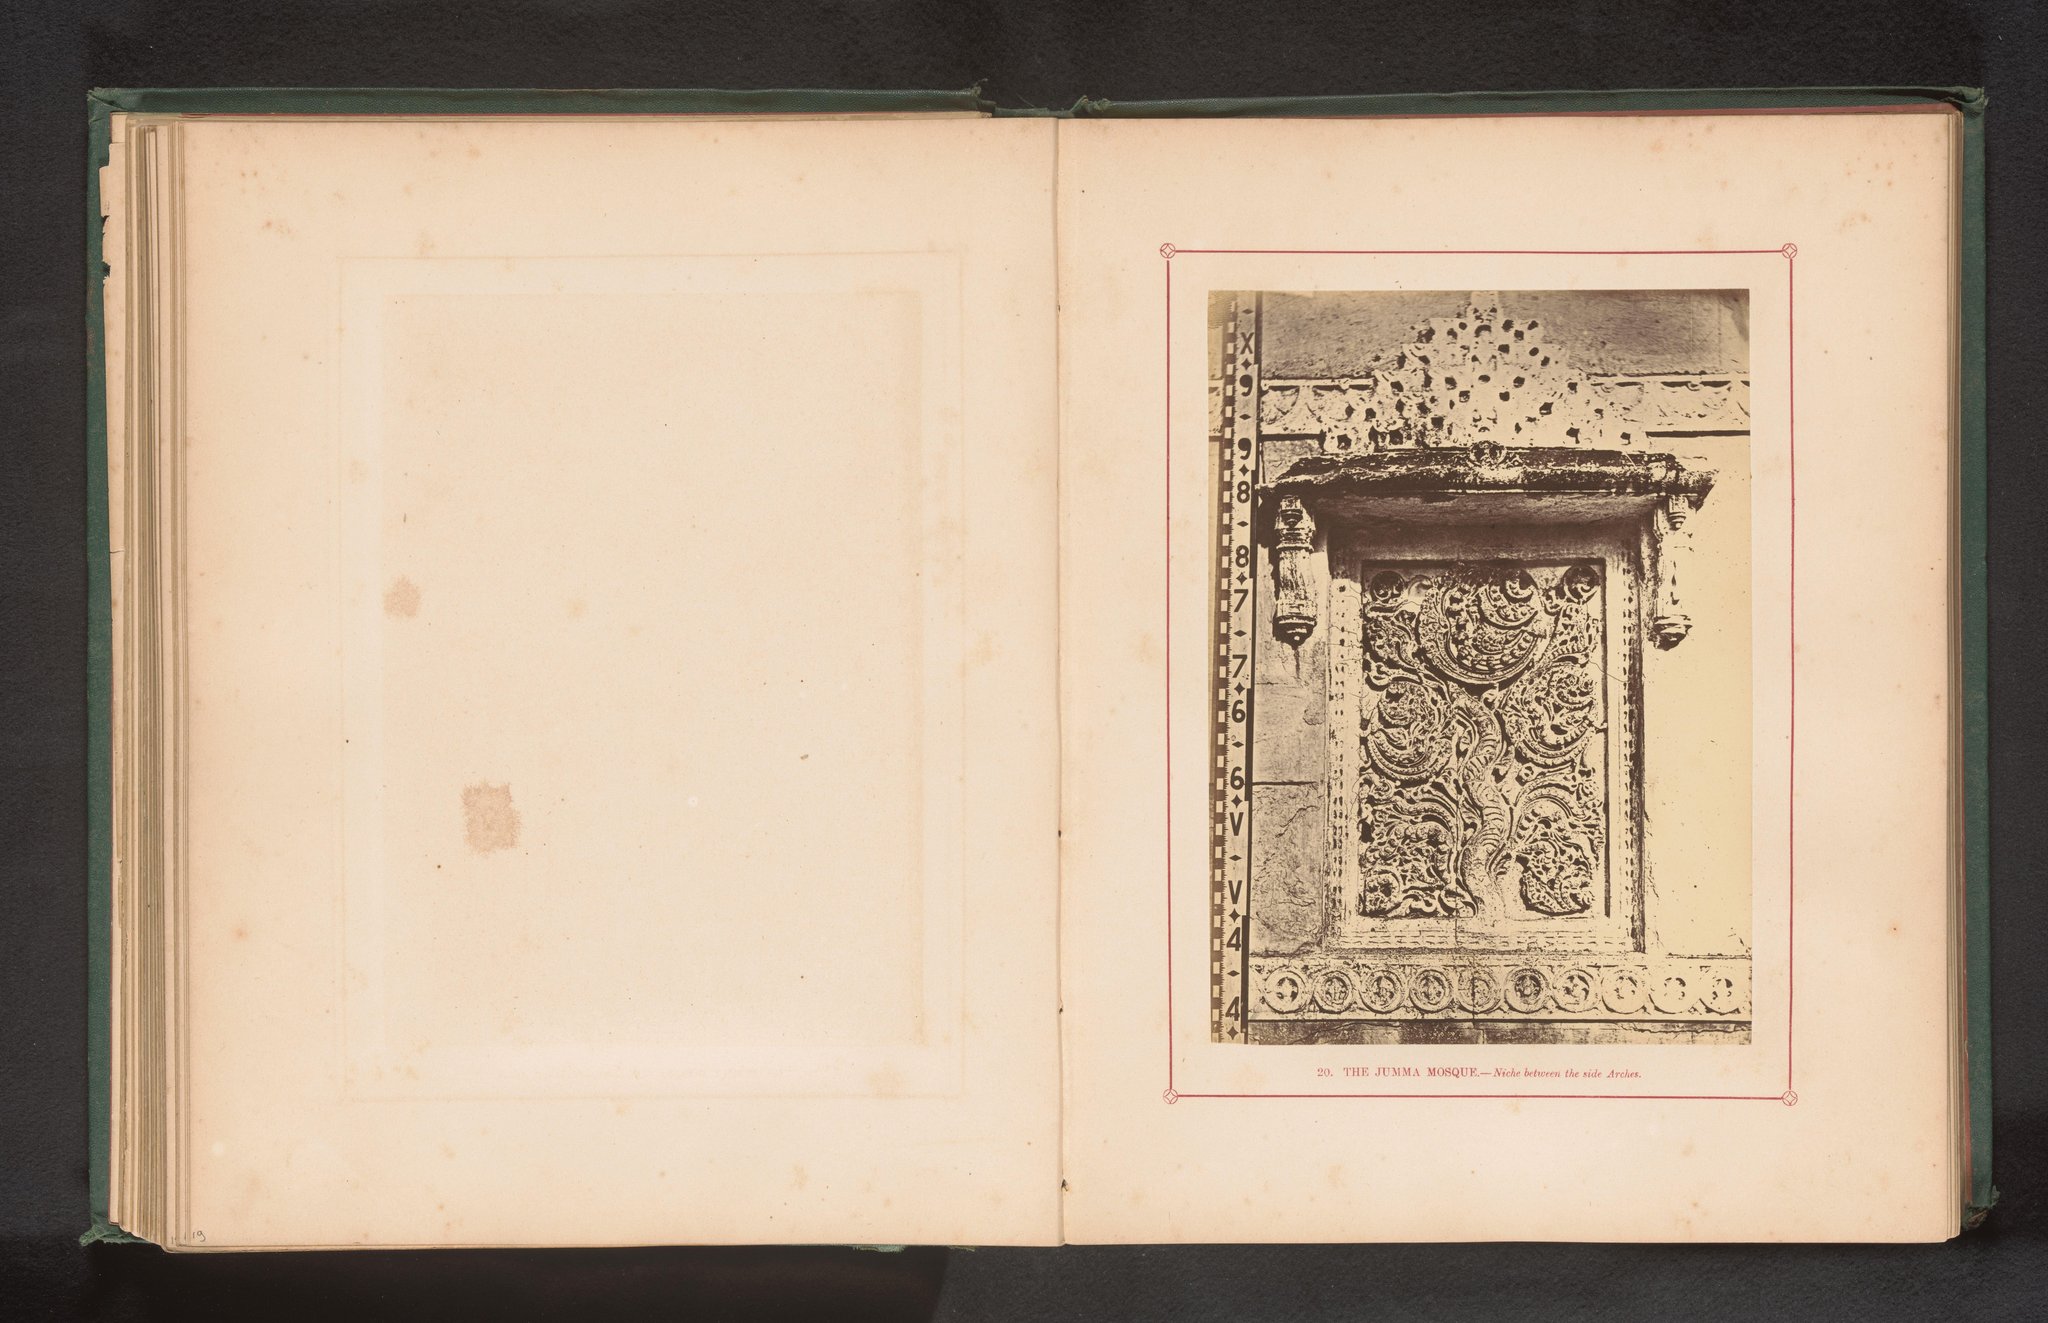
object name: page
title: The Jumma Mosque.- Niche between the side Arches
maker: thomas biggs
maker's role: fotograaf, kapitein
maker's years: 1822-1905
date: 1856-1866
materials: photographic support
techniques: albumen print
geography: ahmedabad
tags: temple, shrine ~ islam, mohammedanism, ornamenting, decorating ~ applied arts, ornament derived from plant forms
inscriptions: number: ‘20.’